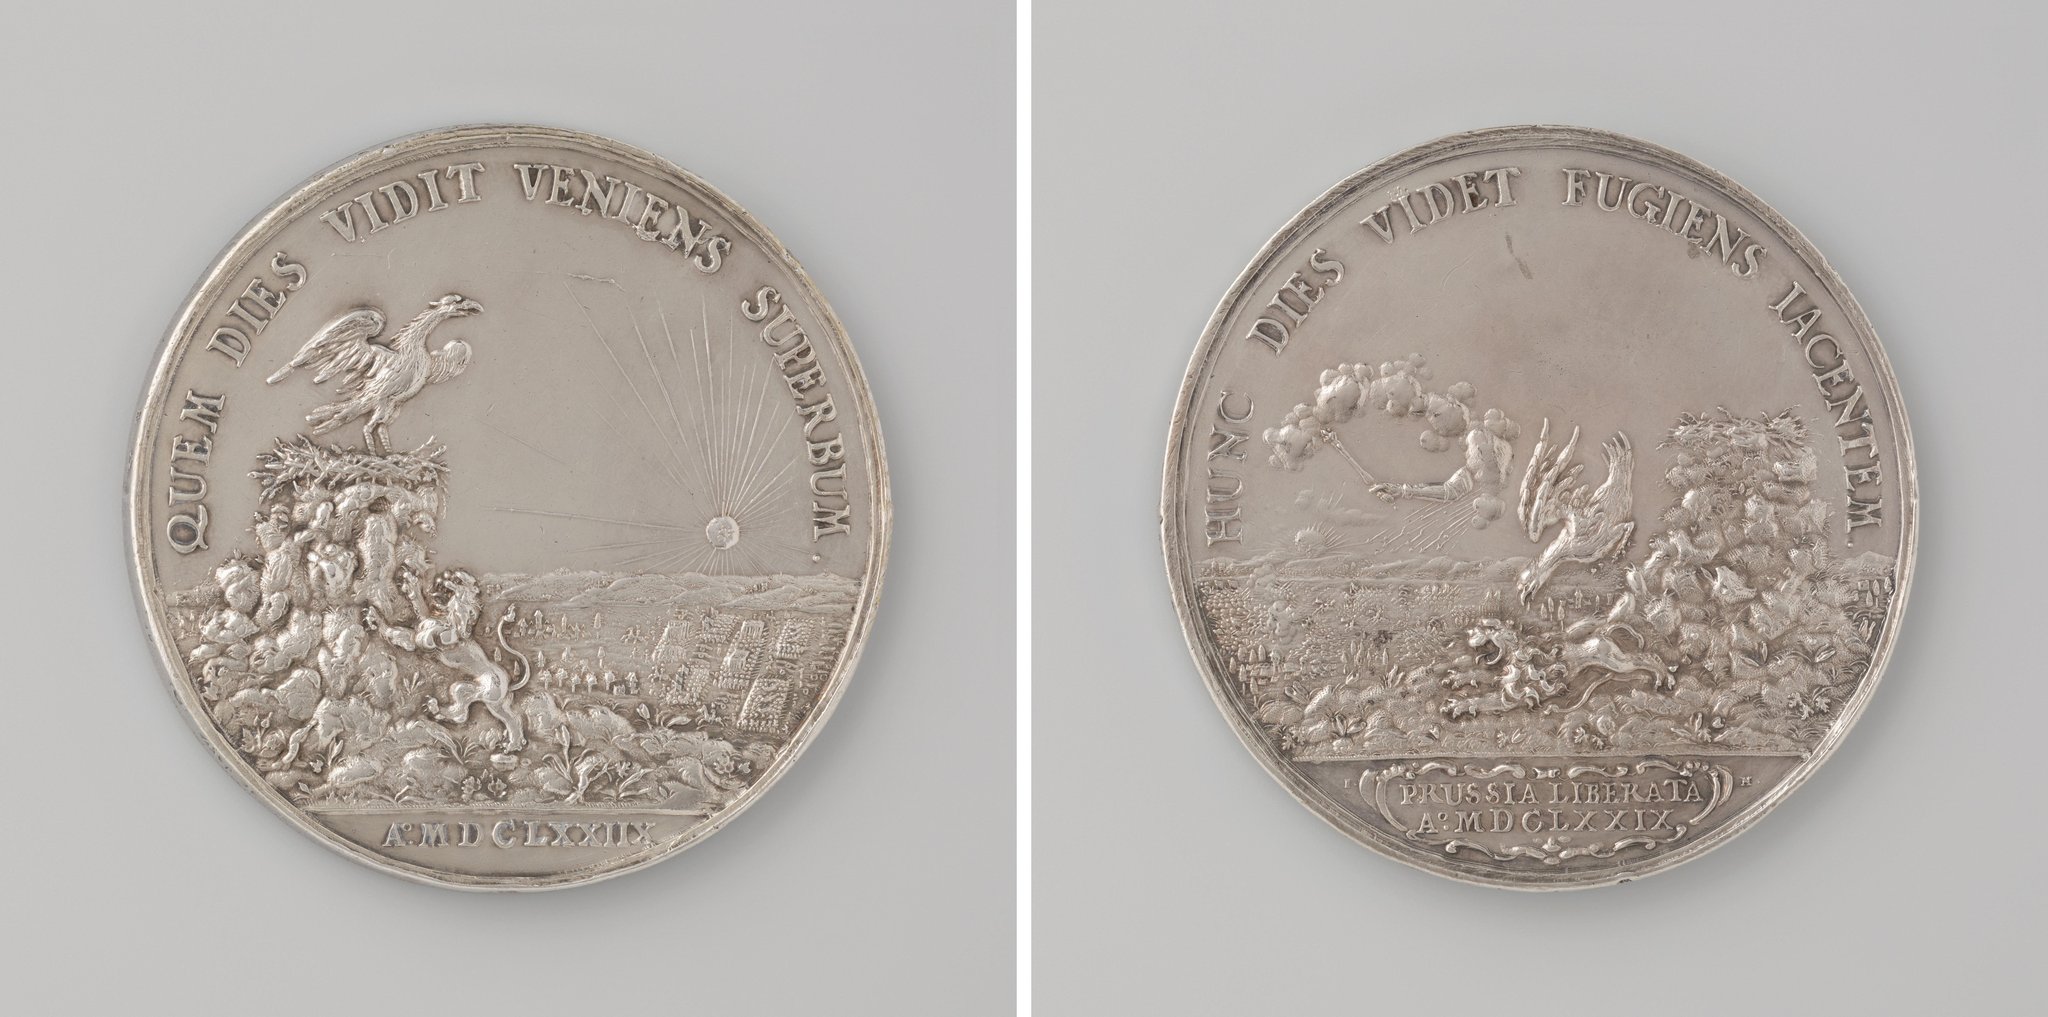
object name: history medal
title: Verjaging van de Zweden uit Pruisen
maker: johann höhn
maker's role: medailleur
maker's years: 1637-1693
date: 1679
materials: silver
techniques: striking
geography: danzig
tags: pruisen, noordse oorlogen, schonense oorlog, verdrijving van de zweden uit pruissen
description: Zilveren penning. Voorzijde: Noordse leeuw probeert Pruisische adelaar te verdrijven, op achtergrond optrekkende Zweedse leger binnen omschrift. Keerzijde: Noordse leeuw wordt door Pruisische adelaar verjaagd, op achtergrond vluchtende Zweedse troepen binnen omschrift.